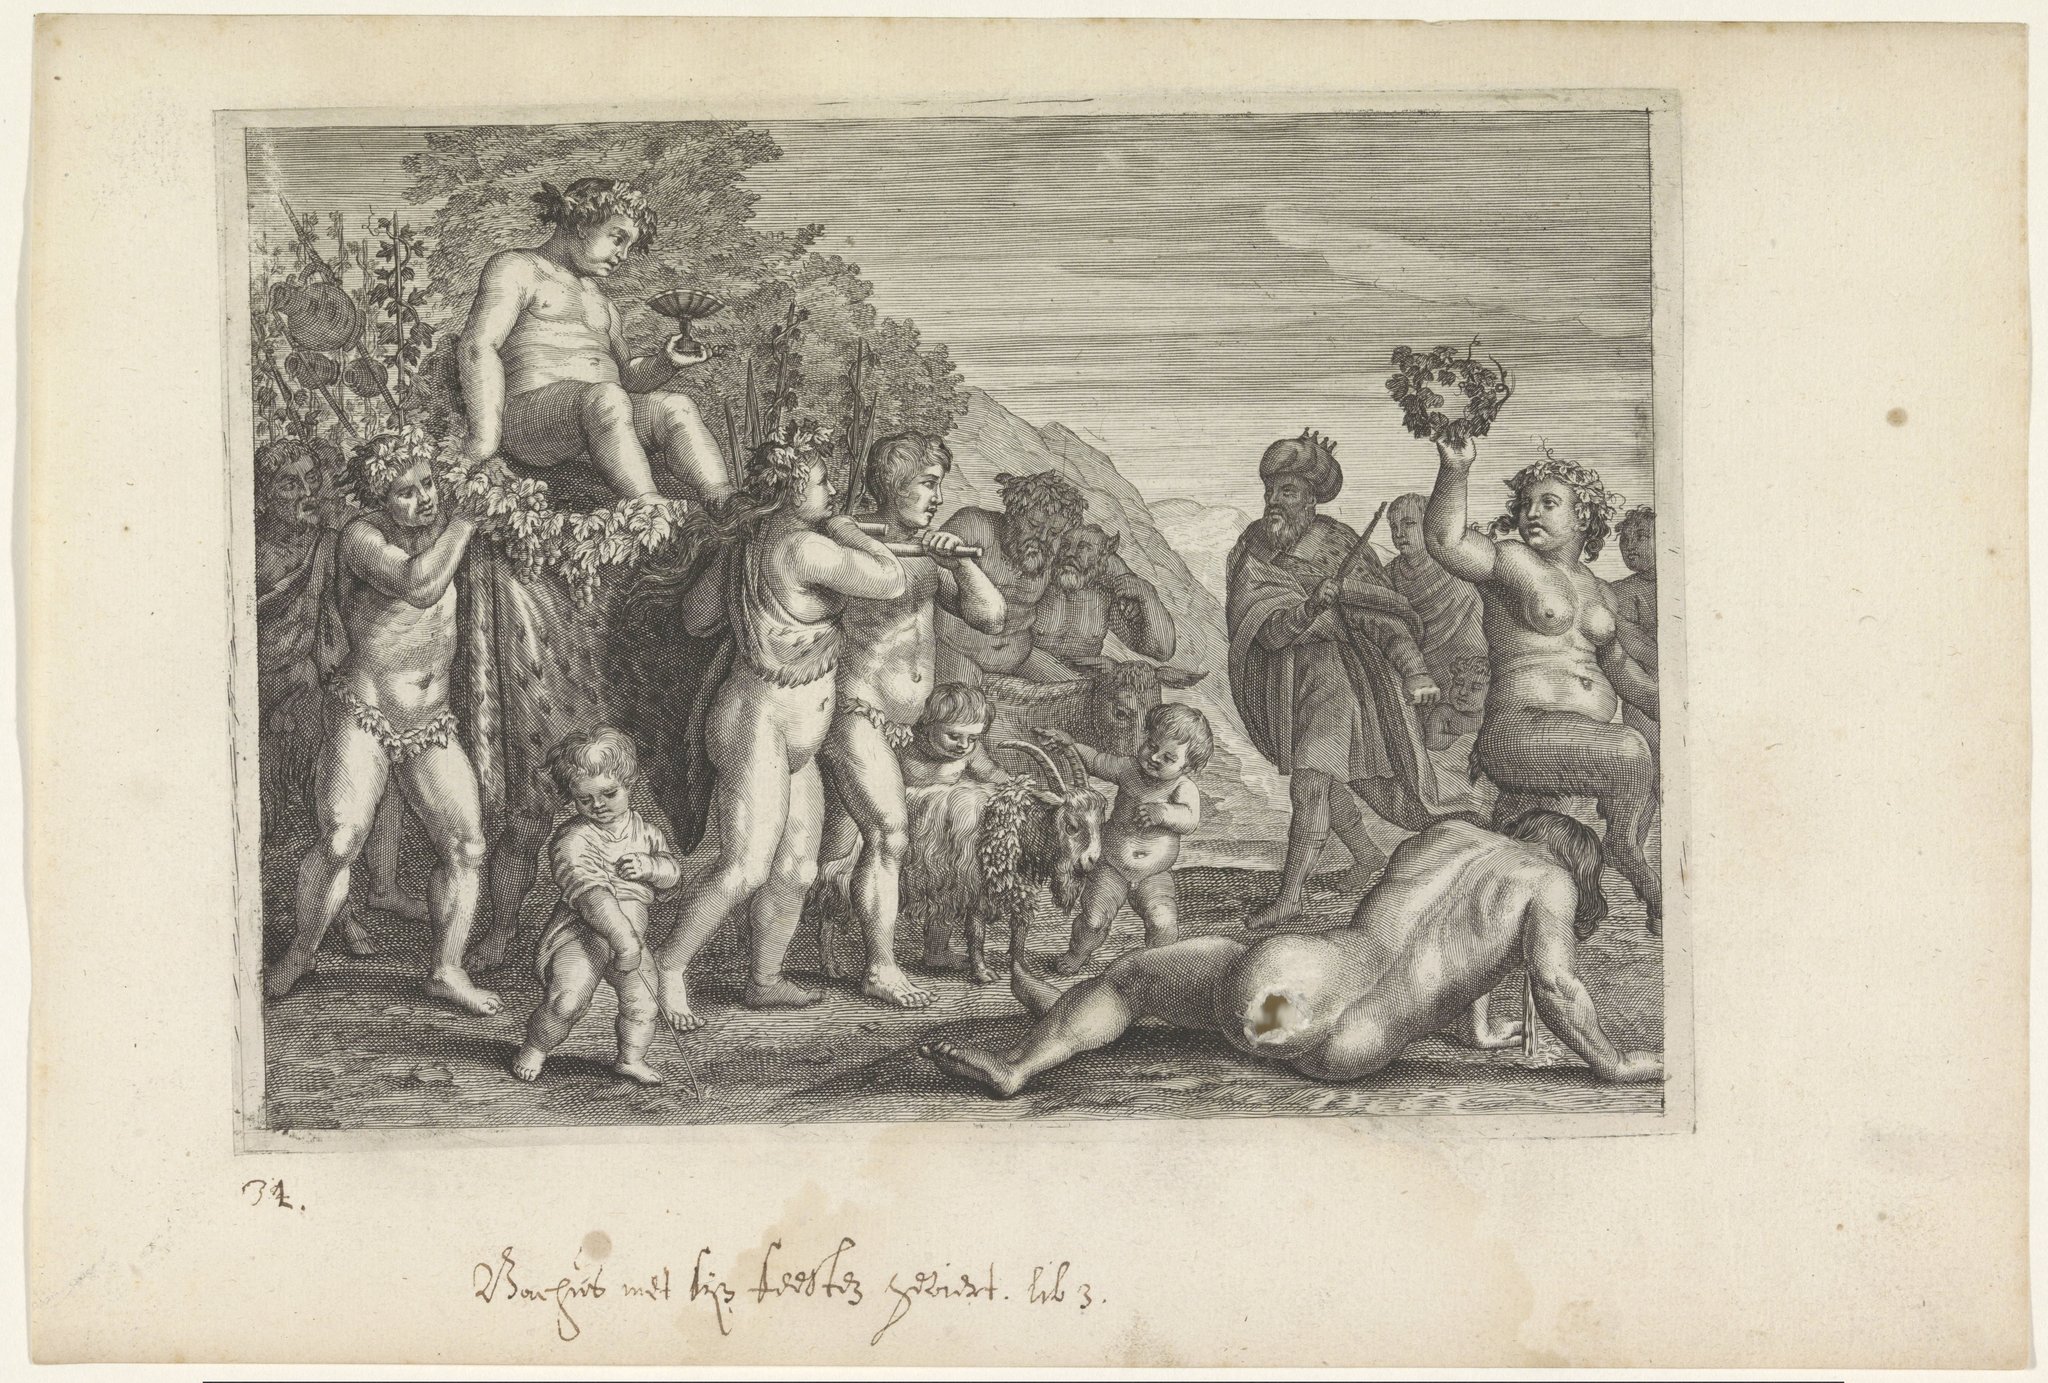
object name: print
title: Metamorfosen van Ovidius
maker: crispijn van de passe (ii)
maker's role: draughtsman, print maker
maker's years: 1594-1670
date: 1636-1670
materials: paper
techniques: engraving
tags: triumph of bacchus; 'carro di bacco' (ripa), (story of) silenus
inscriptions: number: ‘31’, collector's mark: ‘Hinloopen’, annotation: ‘Bachus met sijn feesten geviert. lib. 3’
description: Deze incomplete serie, bestaande uit 77 van de in totaal 85 prenten met scènes uit Ovidius' Metamorfosen, werd in 1709 samen met Ovidius-illustraties van Tempesta, Goltzius en Le Pautre in één album, Schijnvoet nummer 43, ingebonden. In de negentiende eeuw werd deze band weer uit elkaar gehaald.